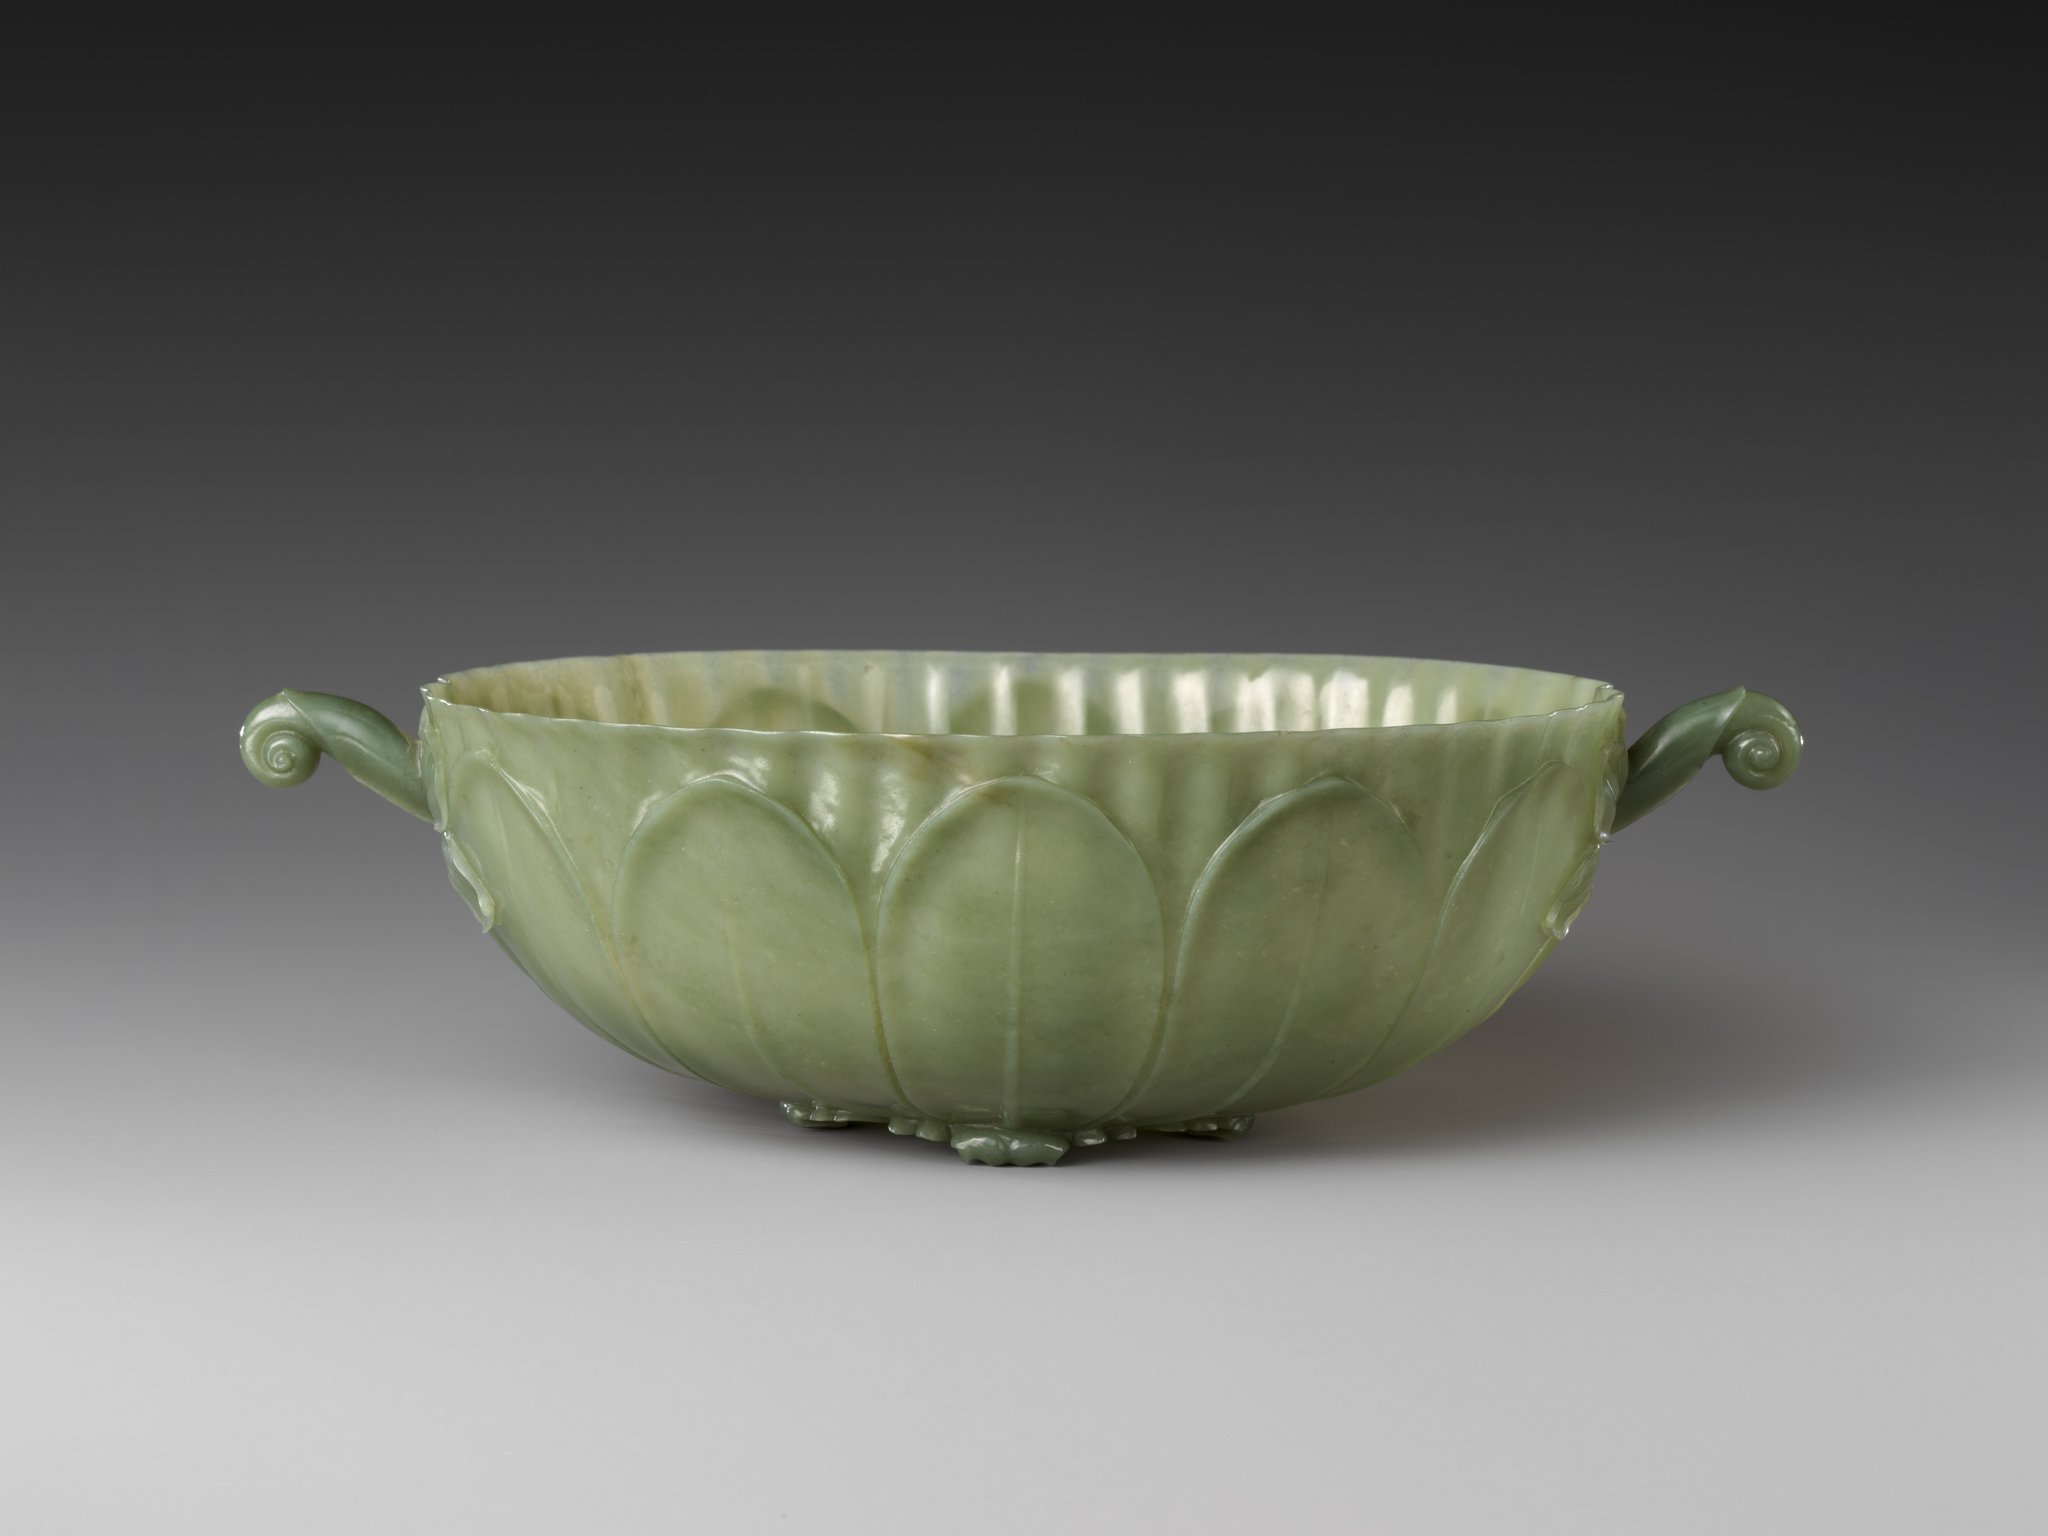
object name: bowl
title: Bowl with floral design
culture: turkish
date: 1701-1800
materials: jade